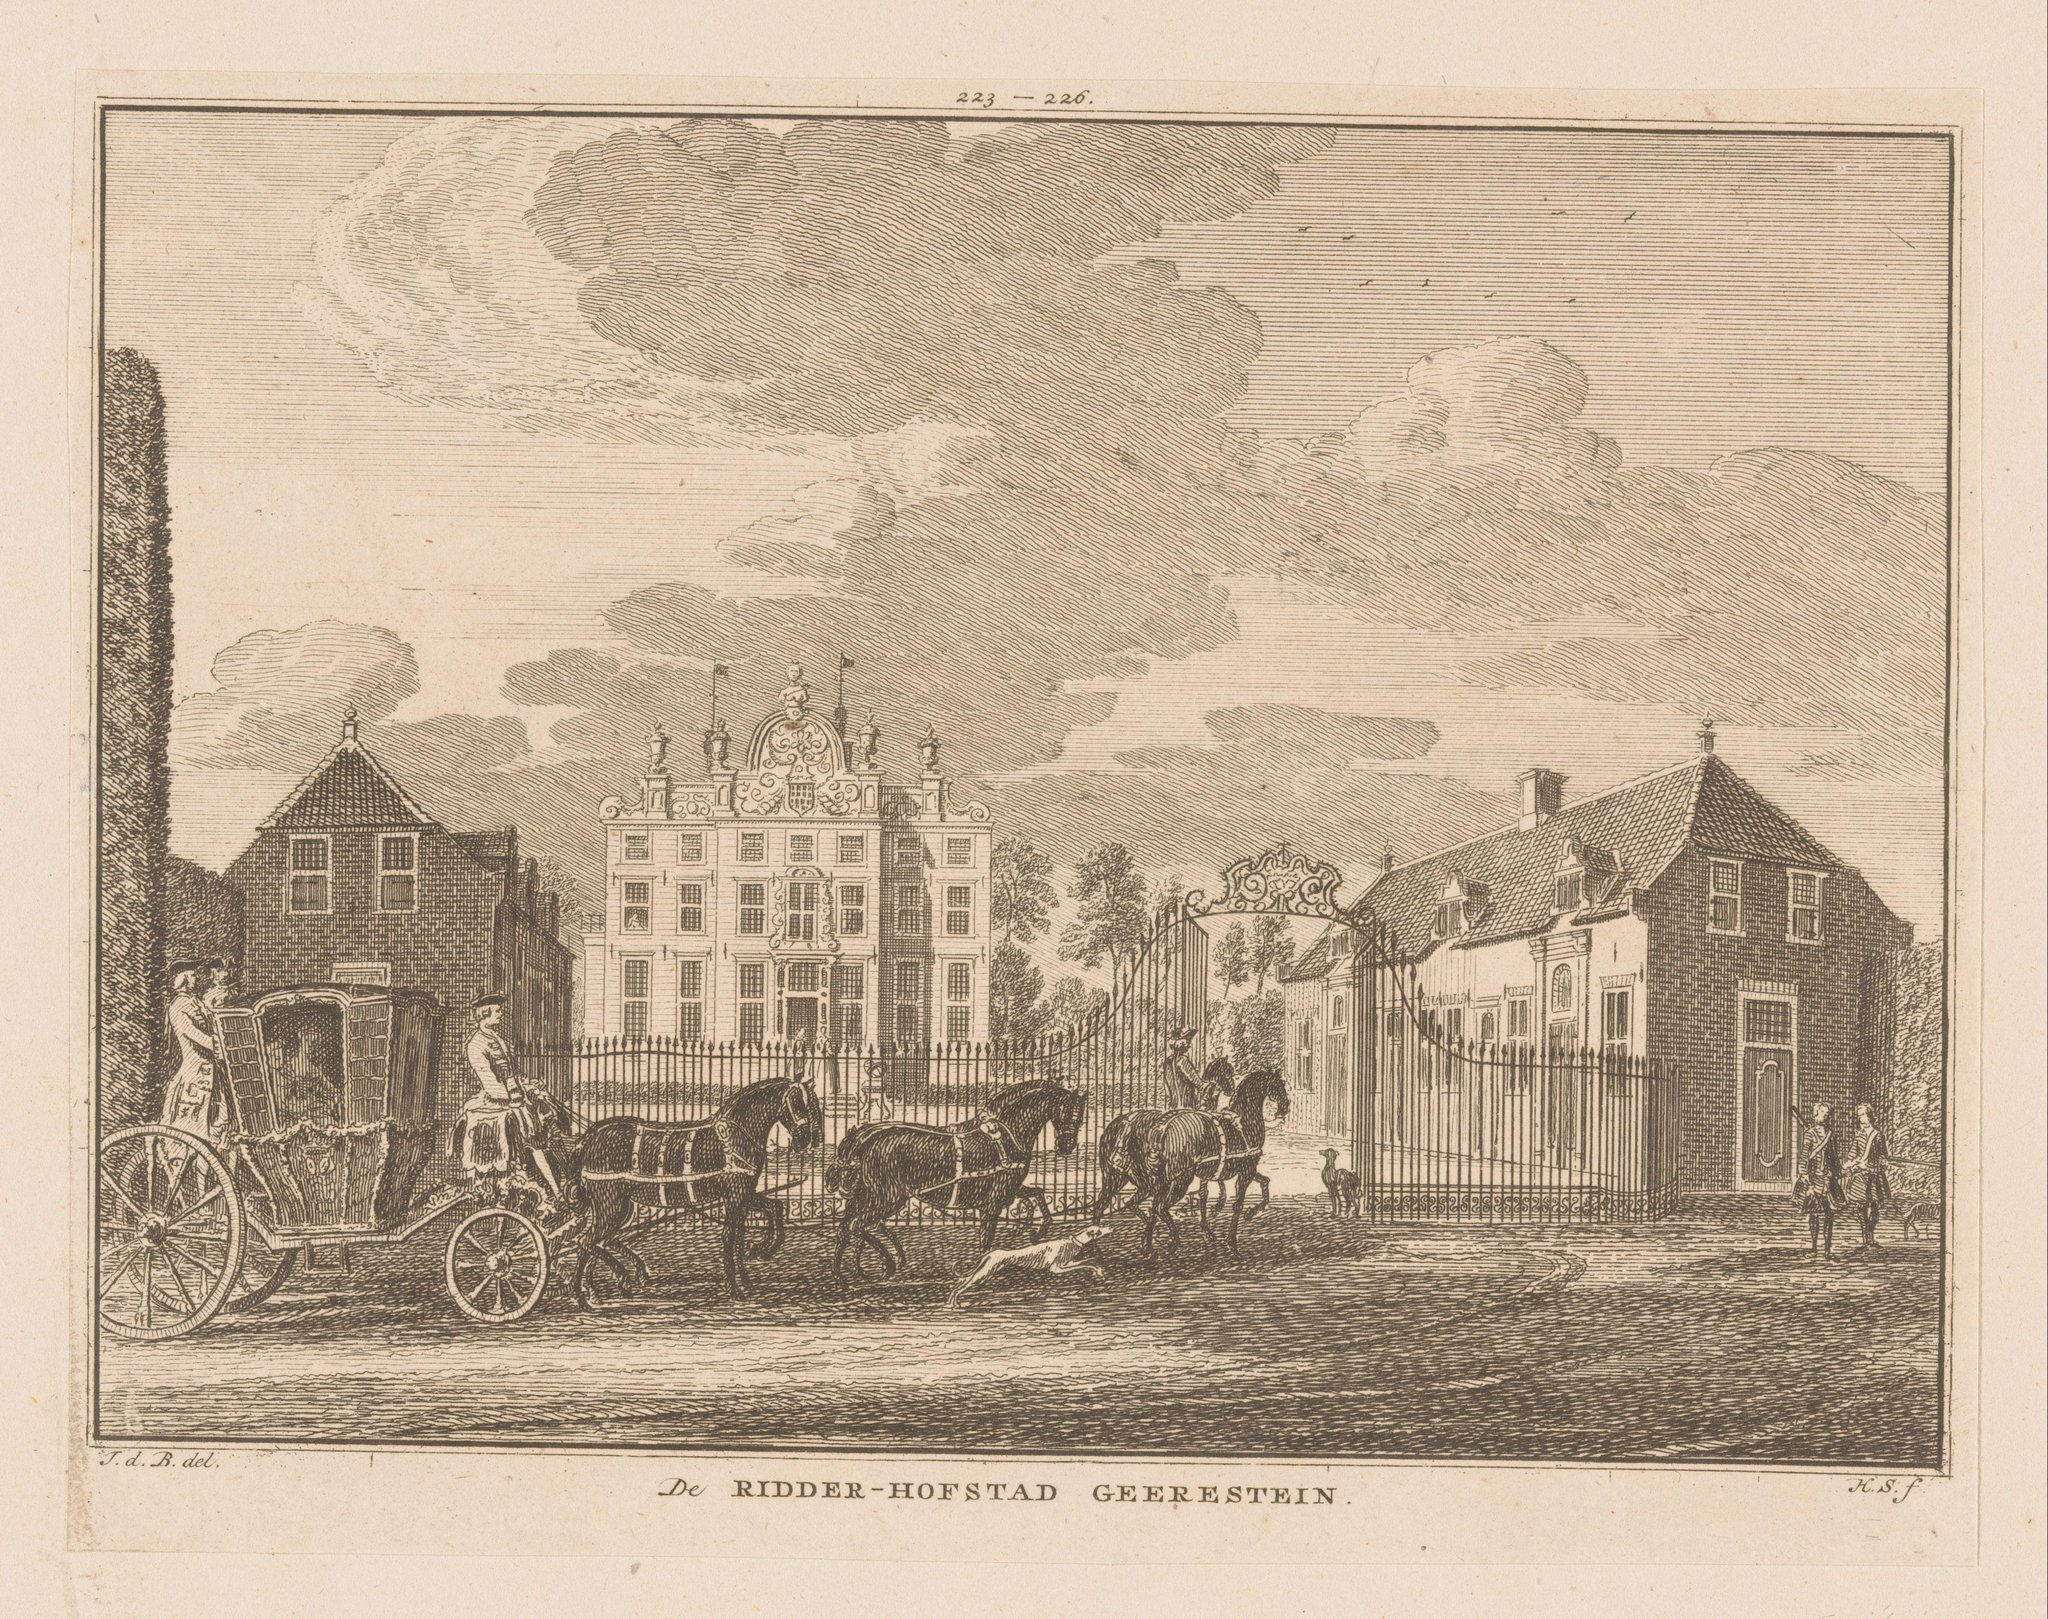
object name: book illustration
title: Gezicht op kasteel Geerestein bij Woudenberg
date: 1745-1774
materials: paper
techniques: engraving, etching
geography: utrecht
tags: castle, landscape with tower or castle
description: Prent uit: Spilman, Hendrik. Het verheerlykt Nederland; of, kabinet van hedendaagsche gezigten (...). 9 dln. Amsterdam: Isaak Tirion, 1745-1774.